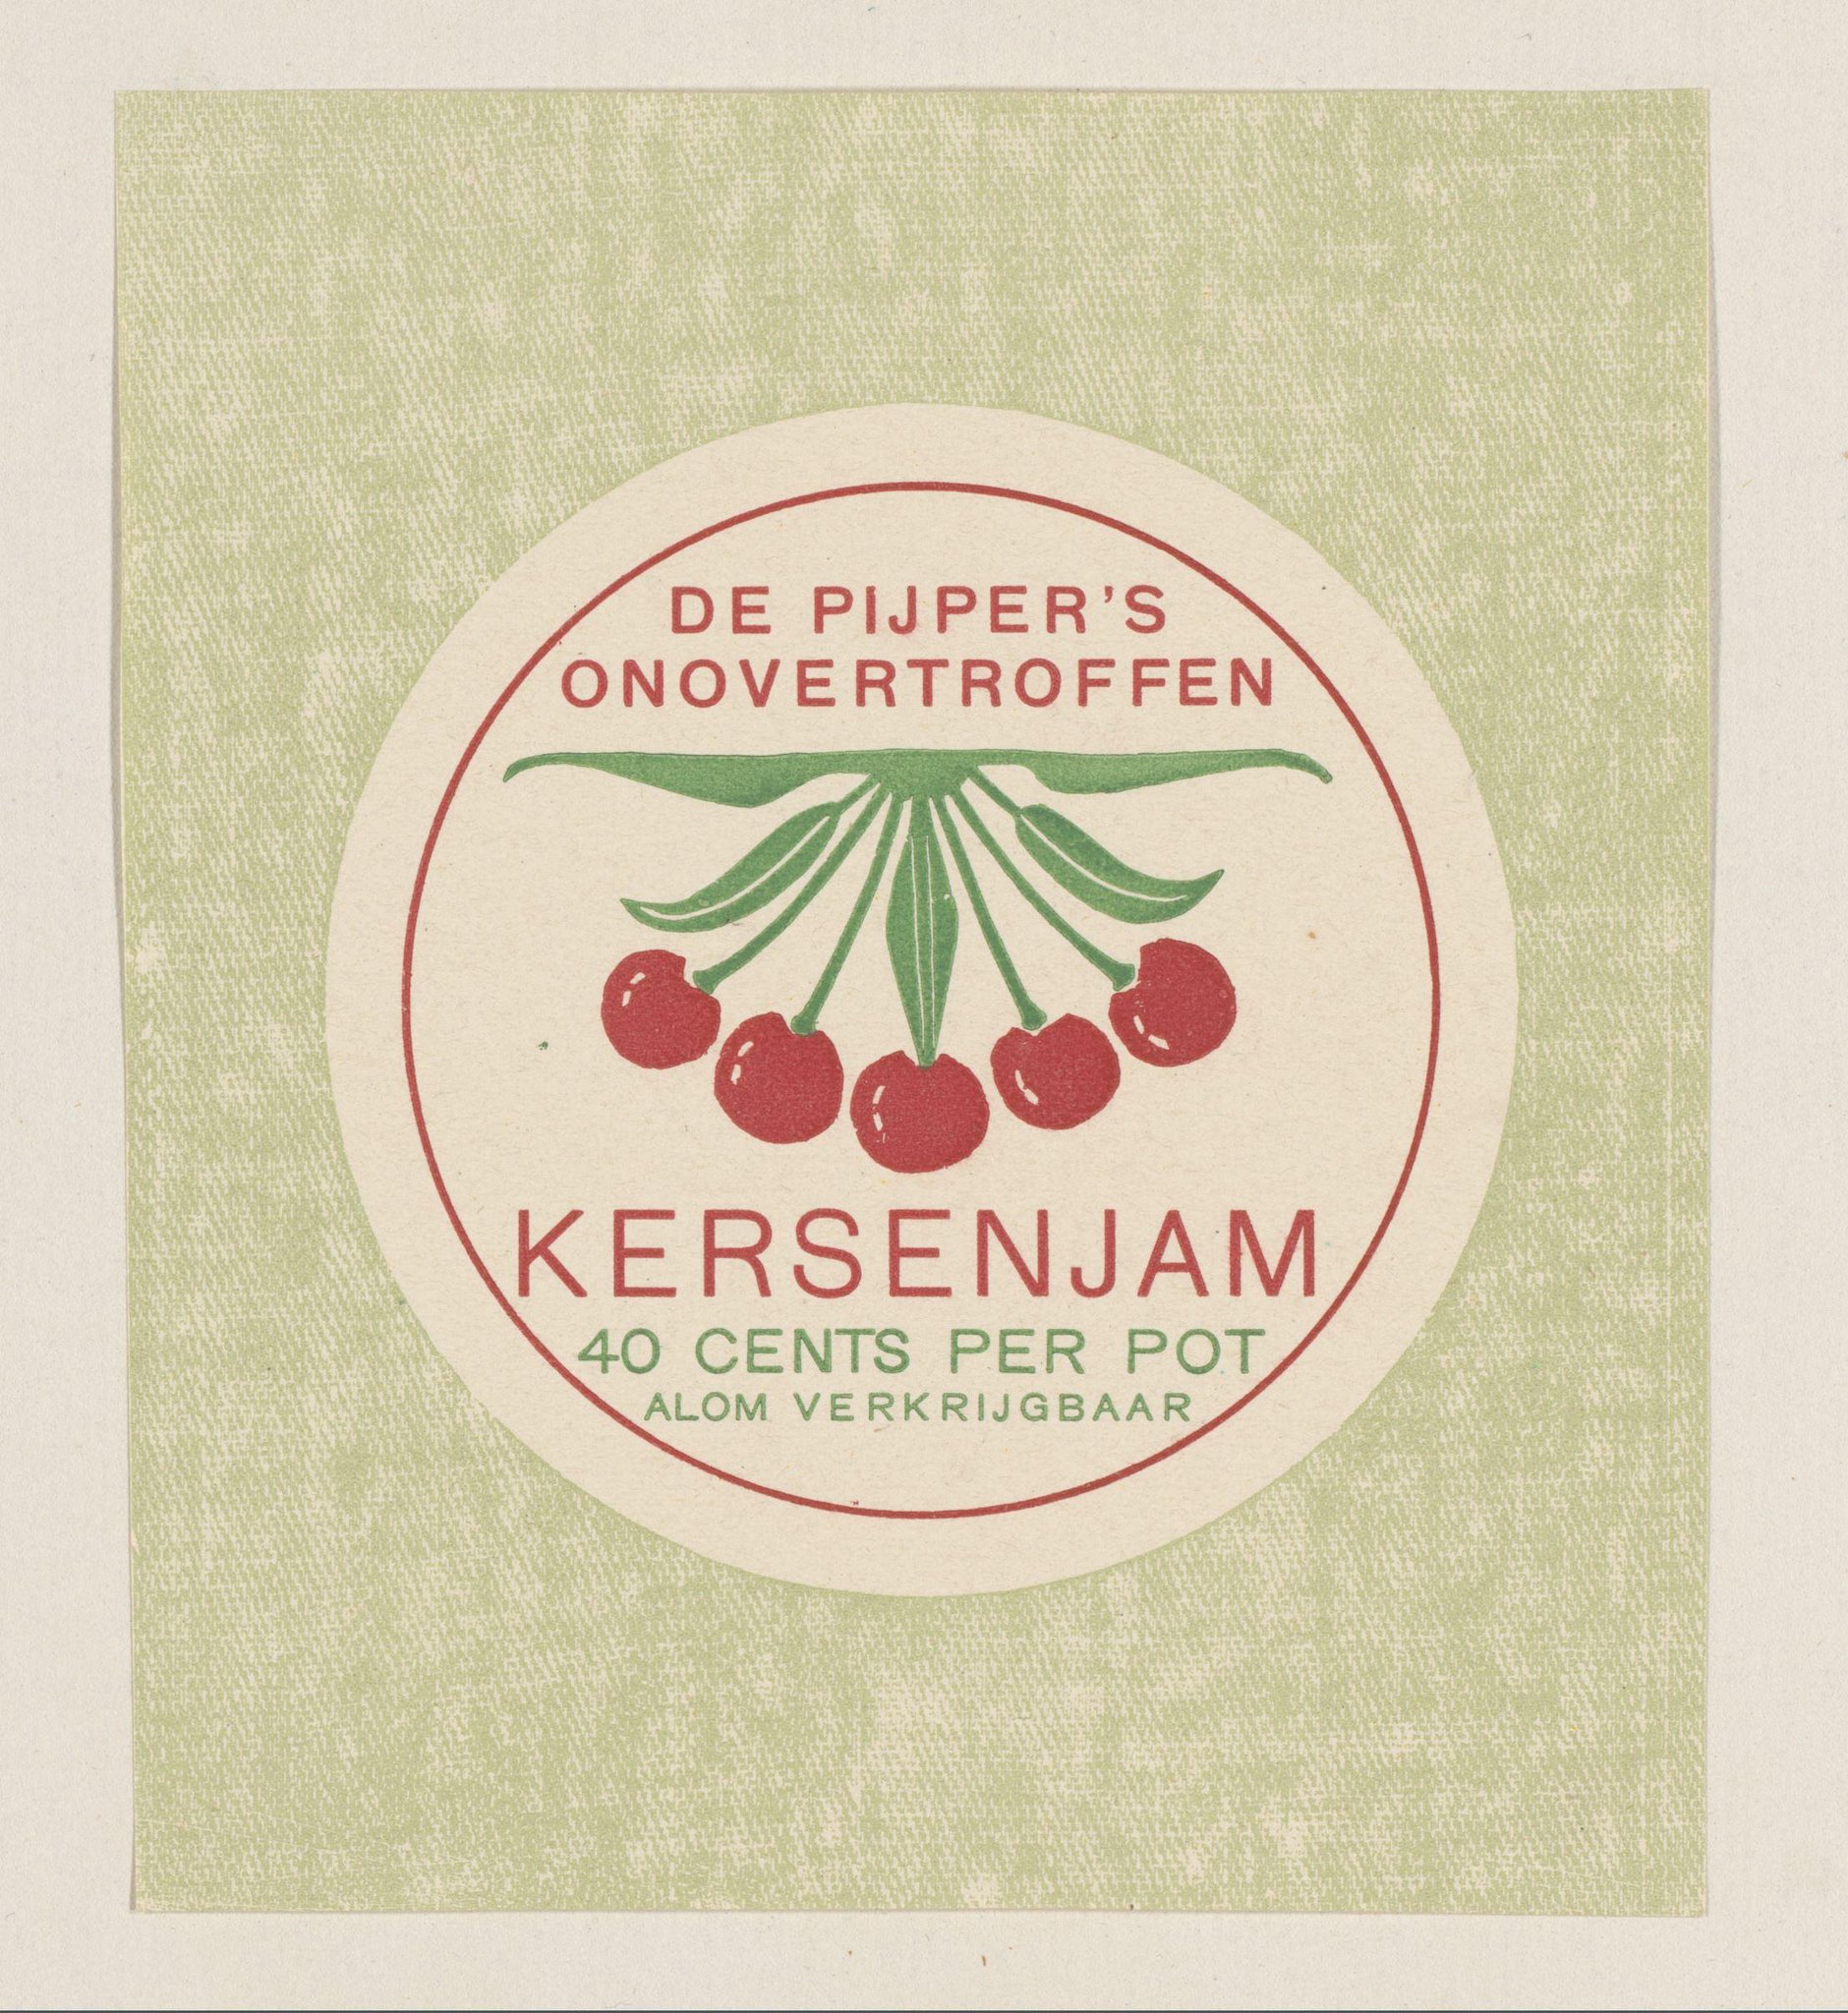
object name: photomechanical print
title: Advertentie voor De Pijper's kersenjam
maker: reinier willem petrus de vries (1874-1953)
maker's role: draughtsman, print maker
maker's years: 1874-1953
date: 1884-1952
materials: paper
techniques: printing block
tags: fruits: cherry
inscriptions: annotation: ‘de V’, annotation: ‘R.W.P. de Vries Jr’